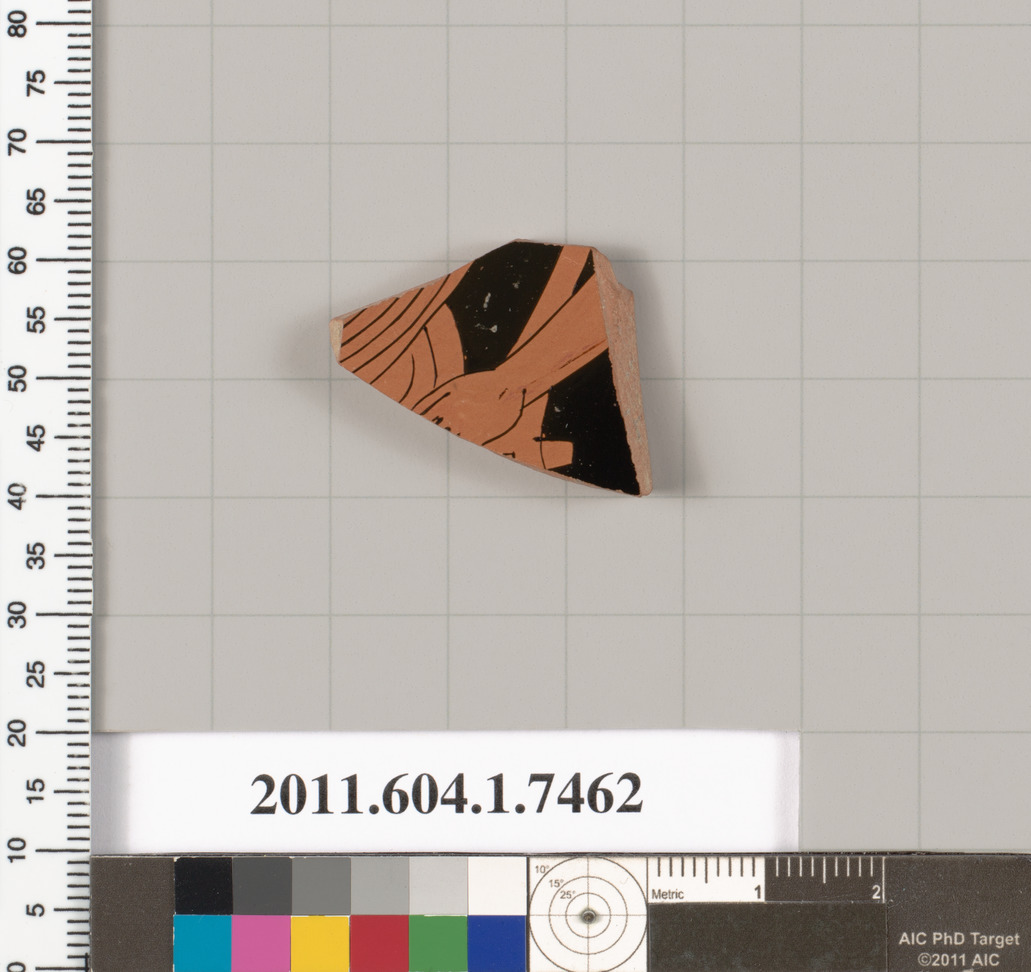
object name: kylix fragment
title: Terracotta fragment of a kylix (drinking cup)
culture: greek, attic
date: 470-460 BCE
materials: terracotta